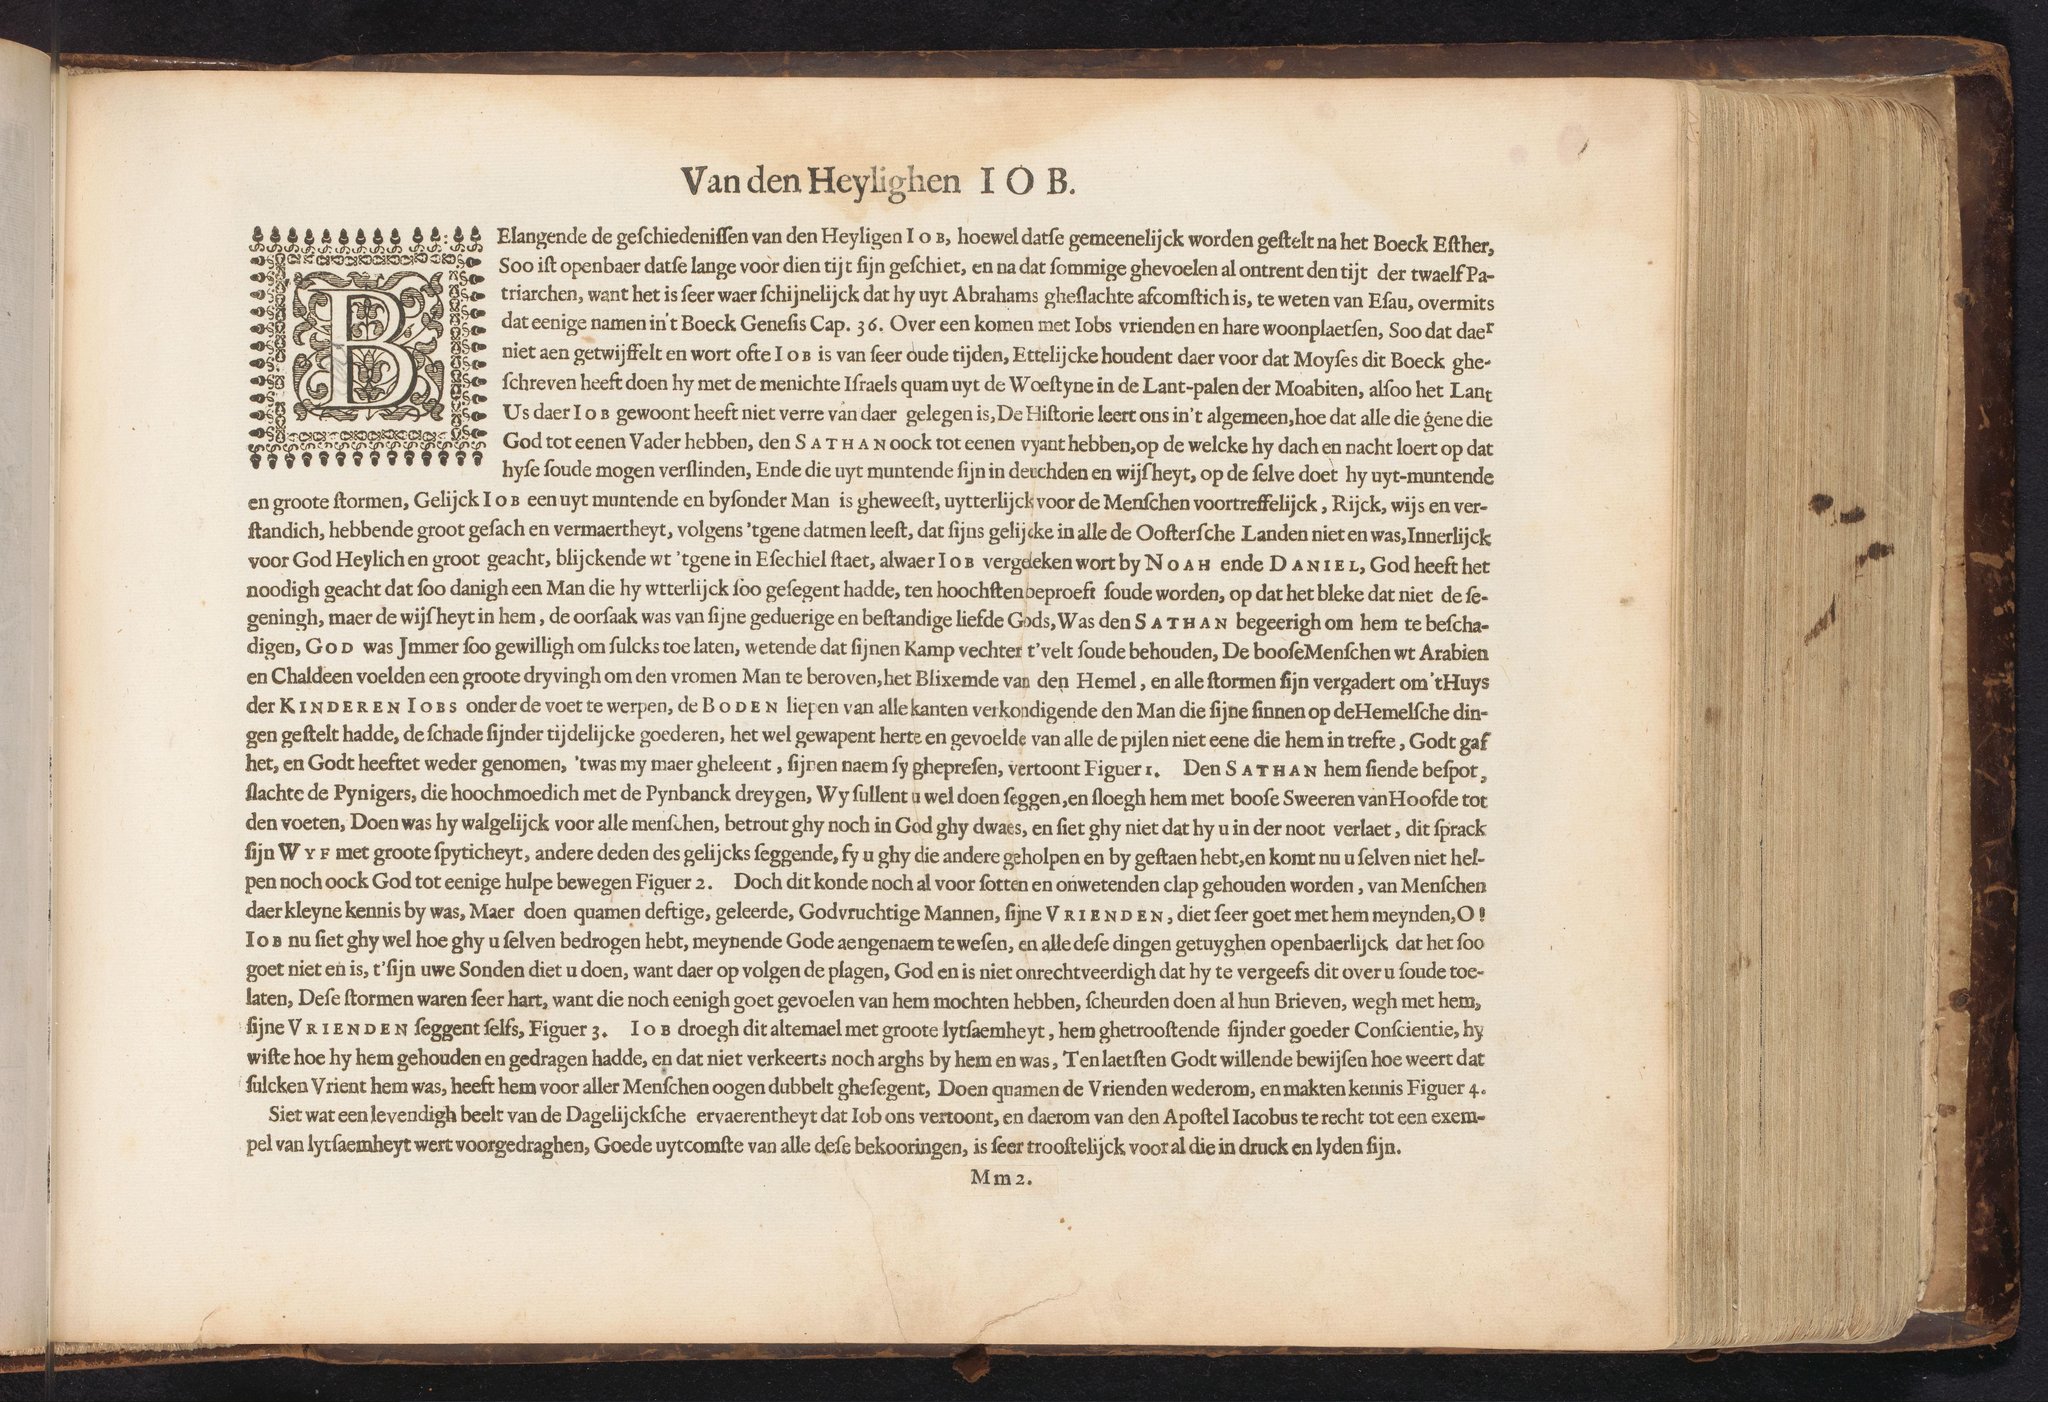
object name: album leaf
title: Van den Heylighen Iob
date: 1646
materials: paper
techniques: letterpress printing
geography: alkmaar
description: Tekstblad bij een serie prenten over de geschiedenis van Job. Linksboven initiaal B. Dit blad maakt deel uit van een album.